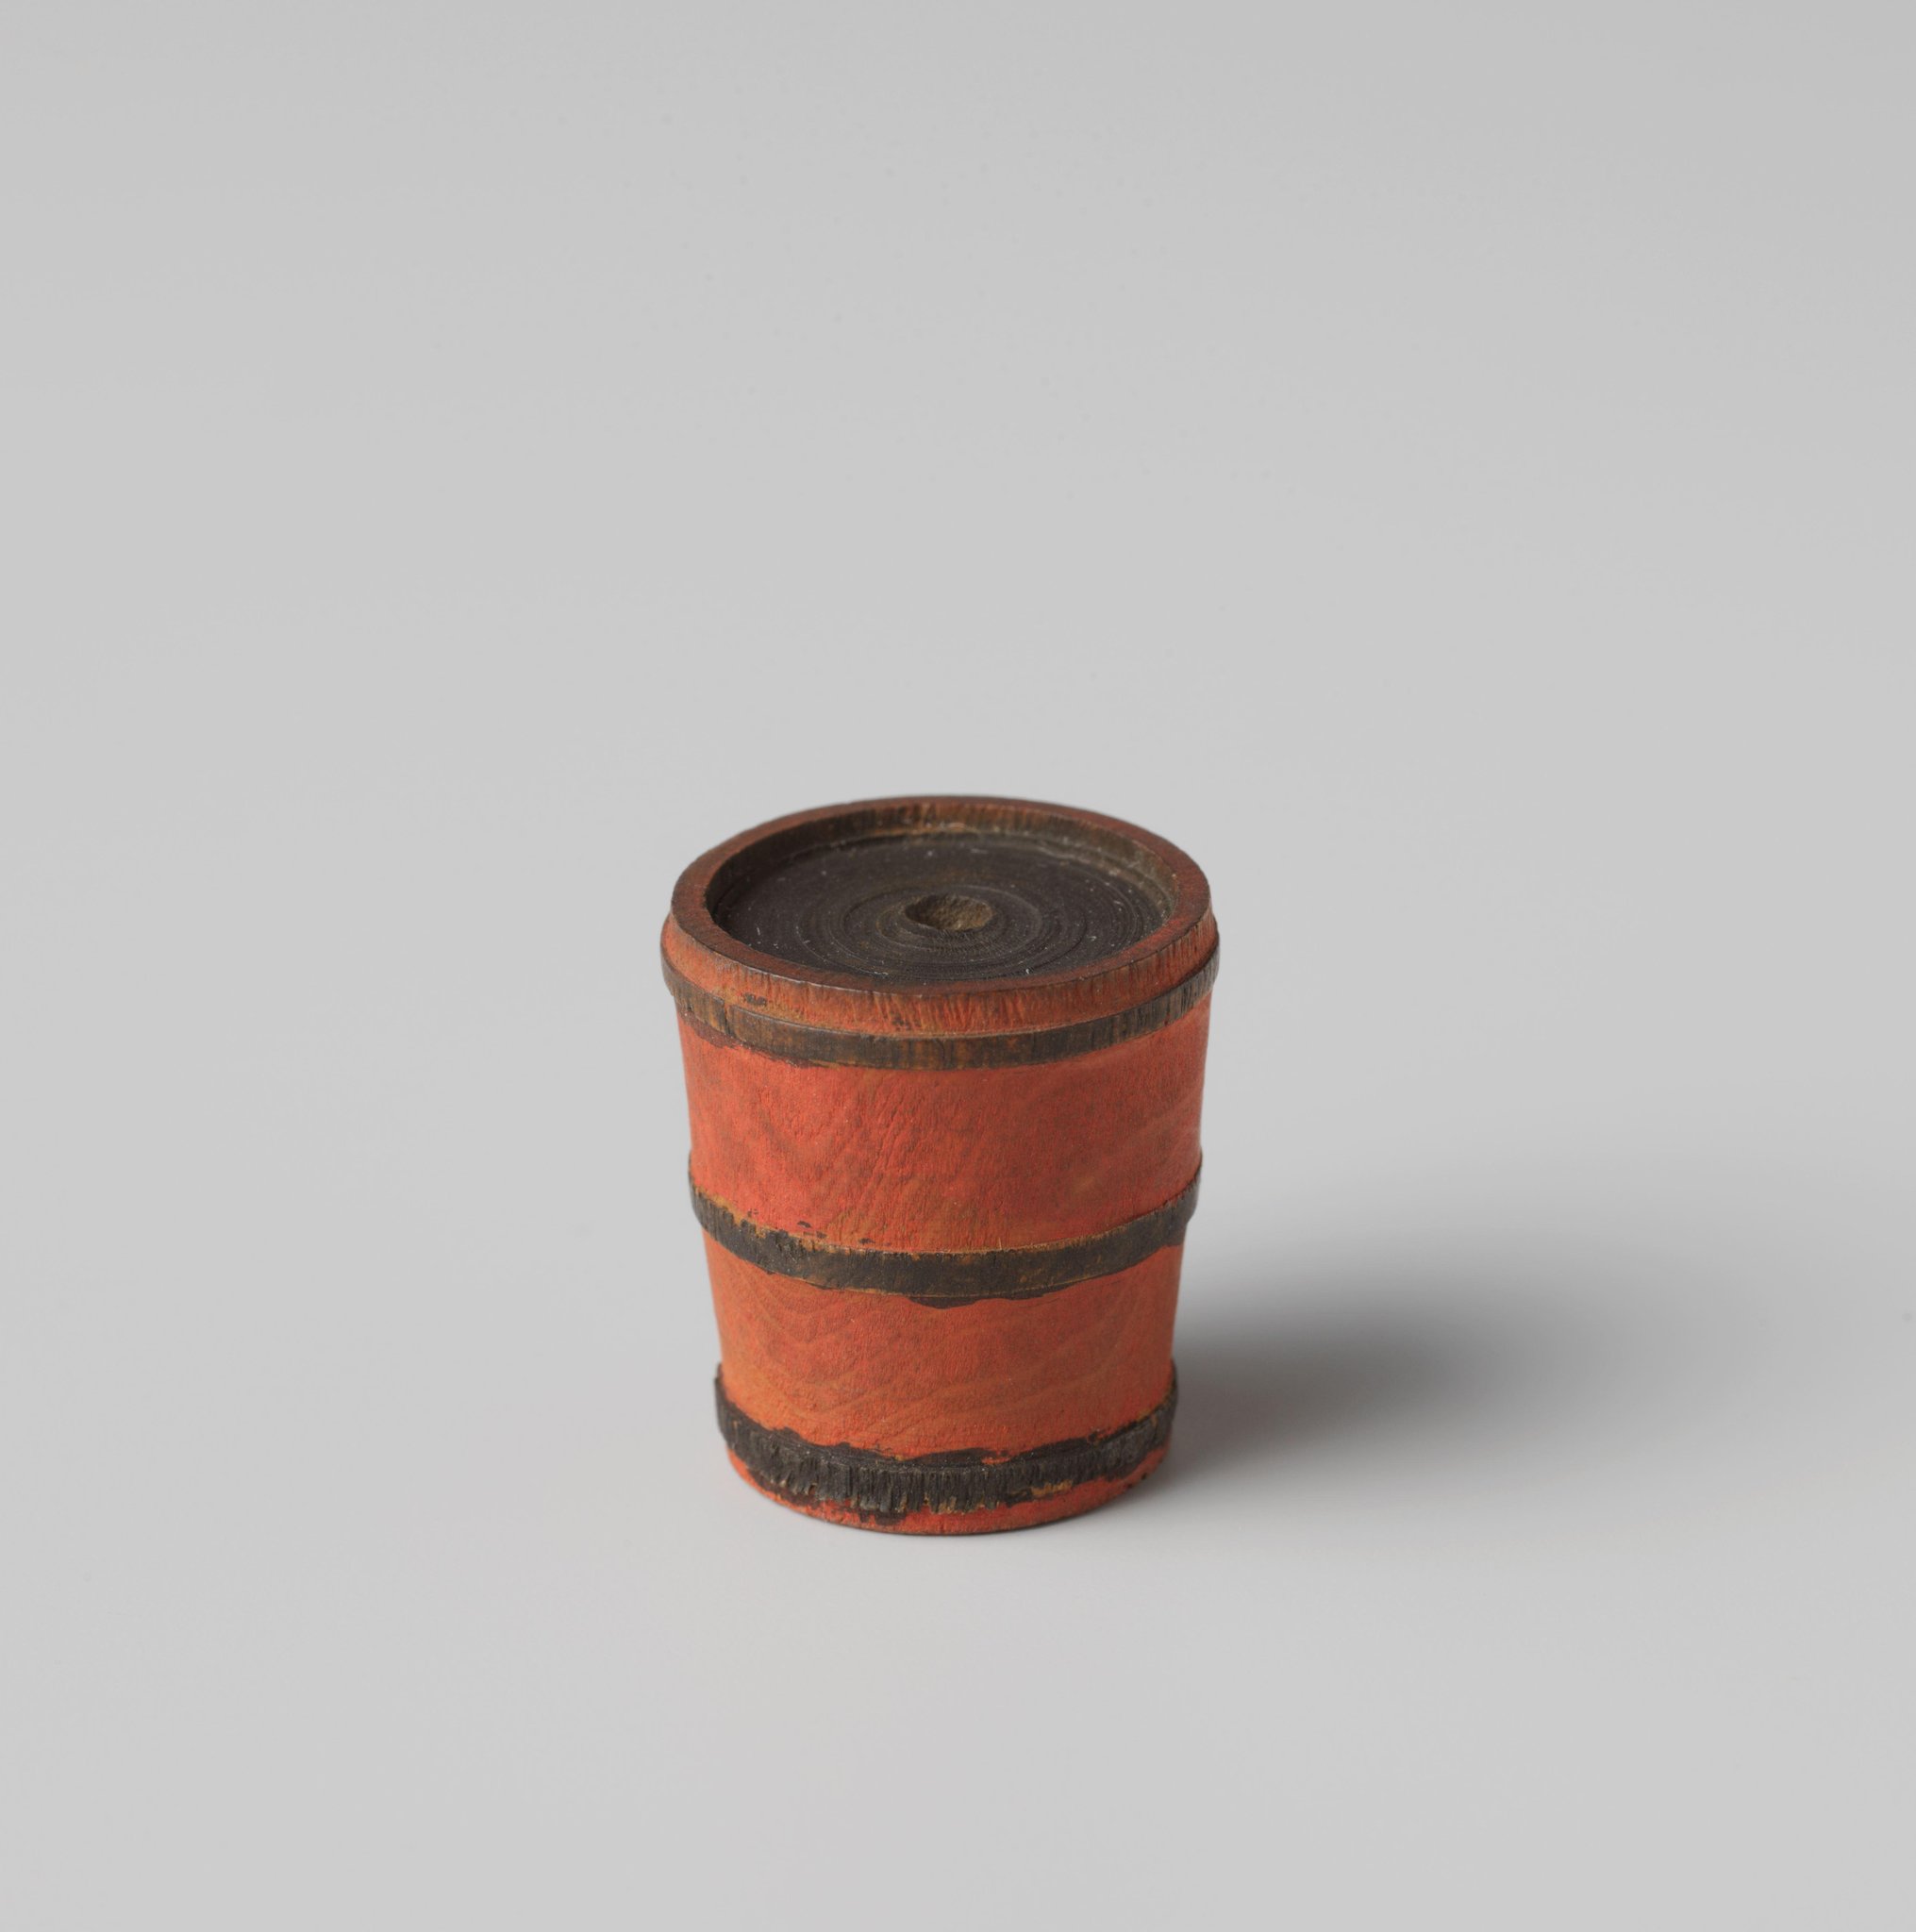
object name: miniature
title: Emmer, massief, beschilderd in rood en zwart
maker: Anonymous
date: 1700-1799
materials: without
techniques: without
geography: amsterdam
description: Emmer, massief gedraaid van rood en zwart geschilderd hout, met drie profielranden.